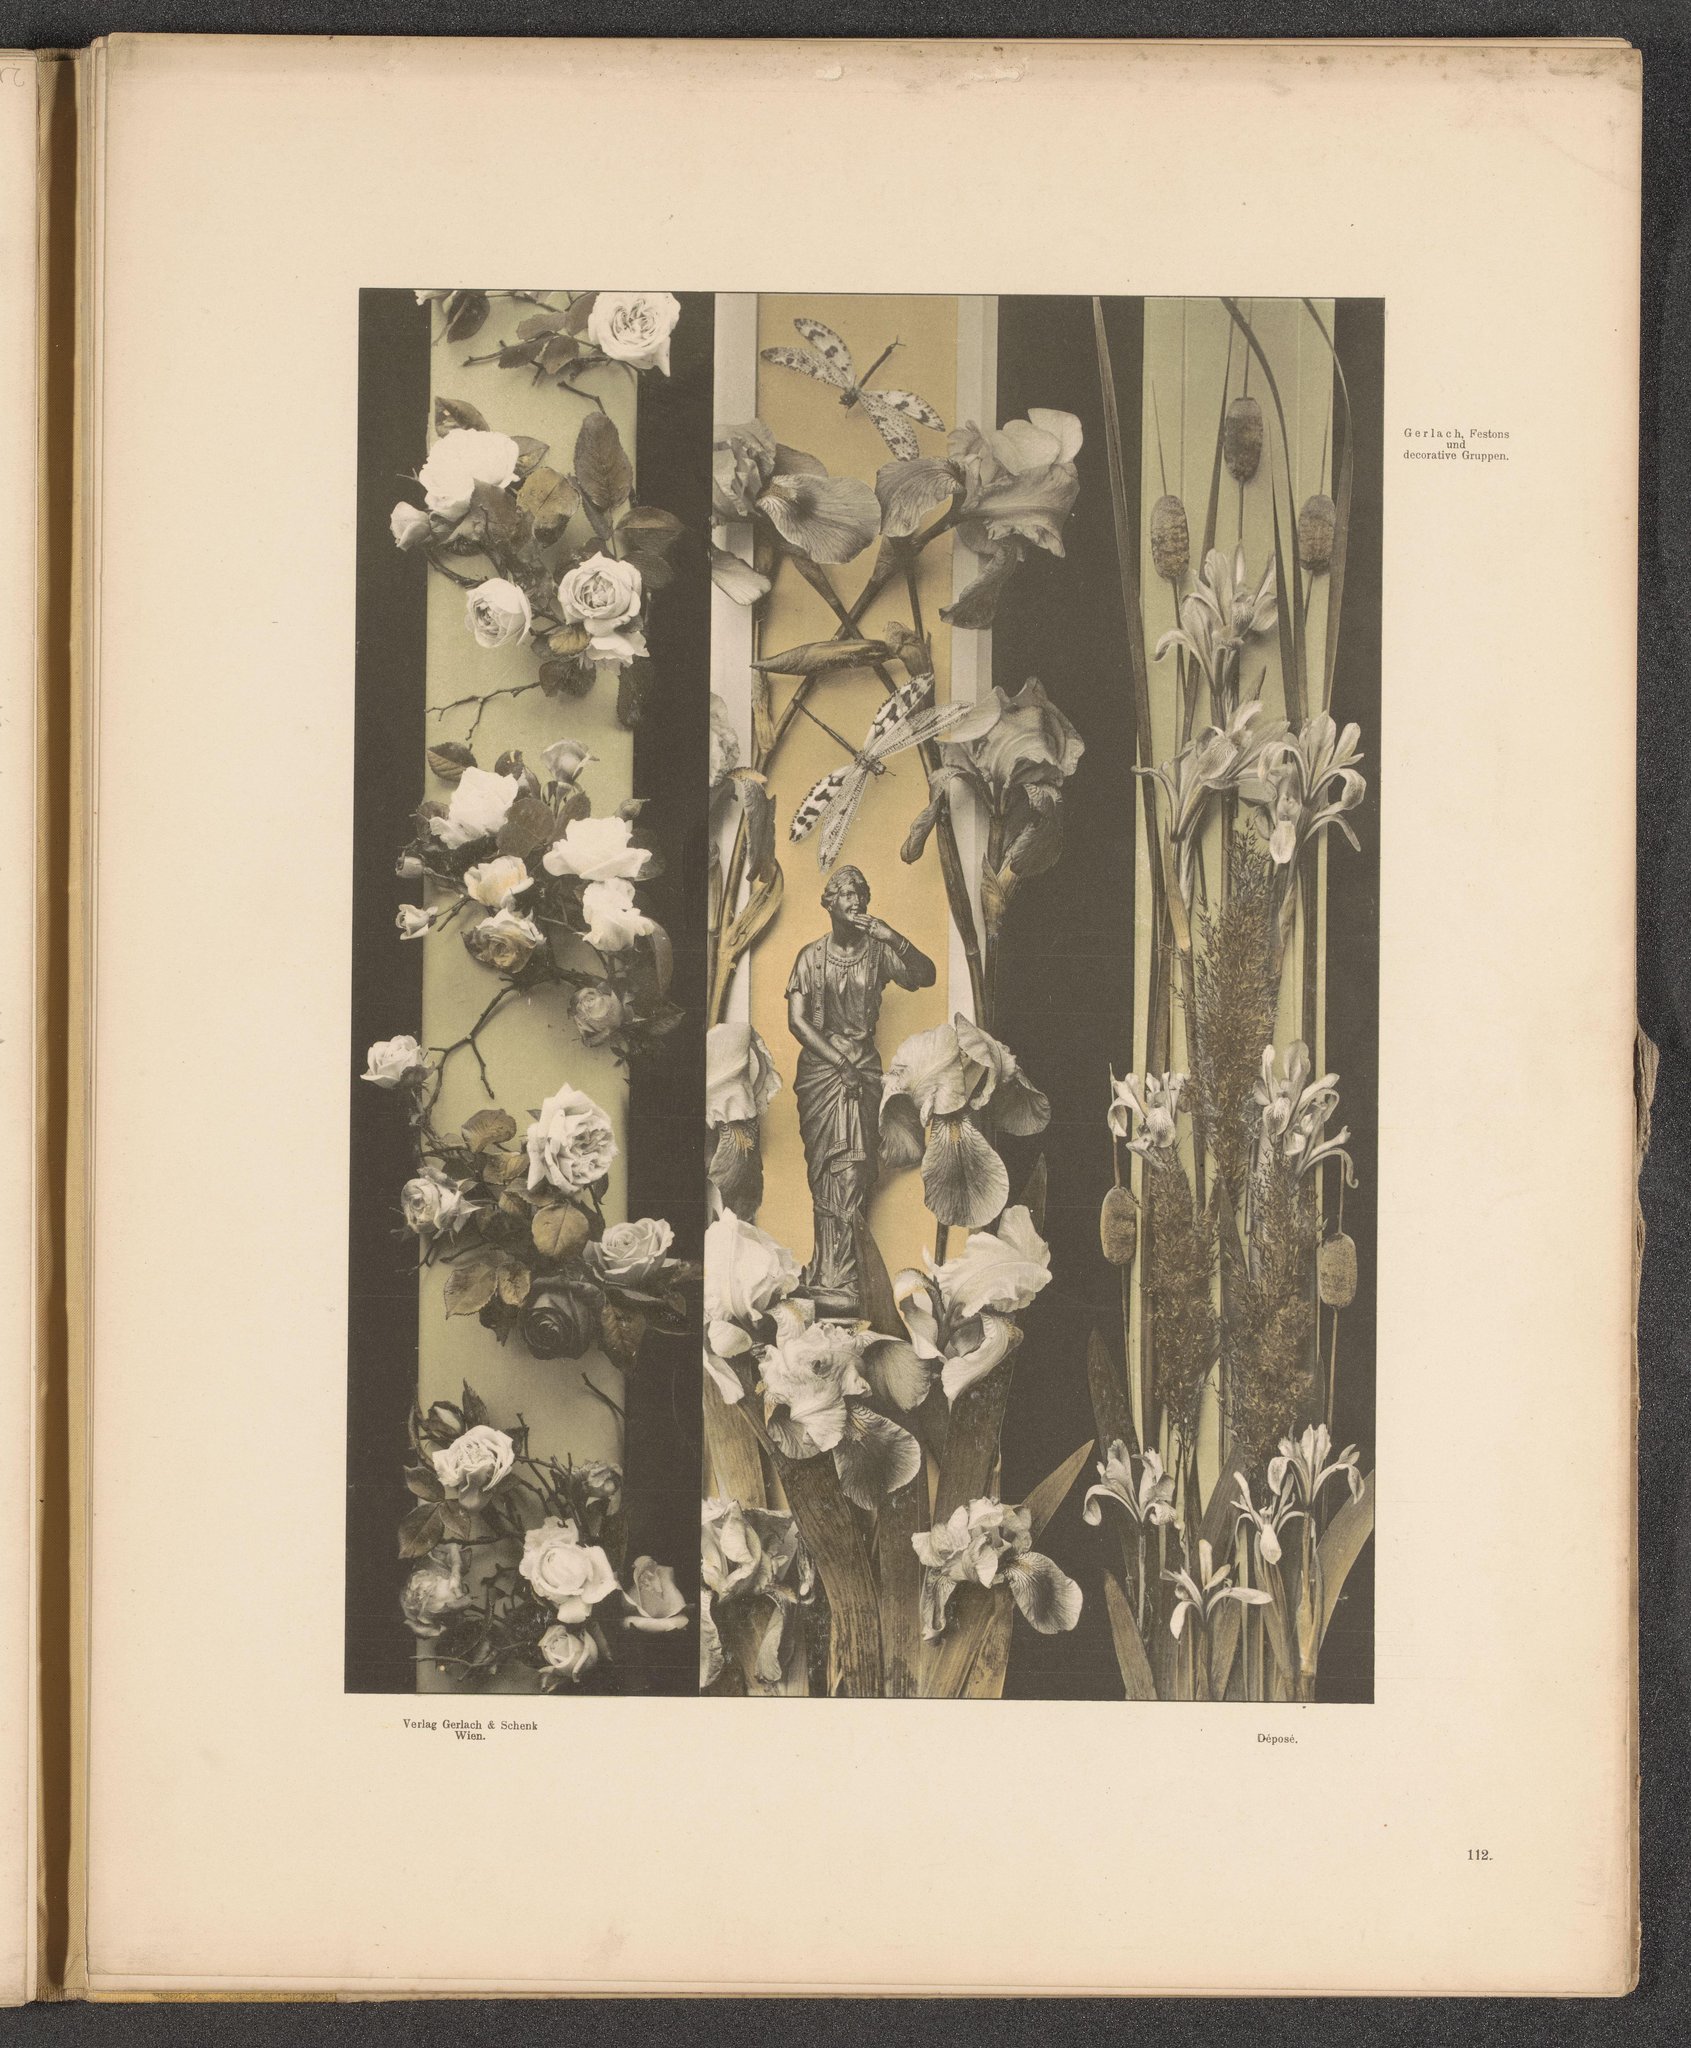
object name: page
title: Sierlijsten met rozen, lissen, libellen en een sculptuur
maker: Anonymous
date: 1887-1897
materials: paper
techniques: photograph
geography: vienna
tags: insects: dragon-fly, sculpture, flowers: lily, flowers: rose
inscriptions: number: ‘112.’